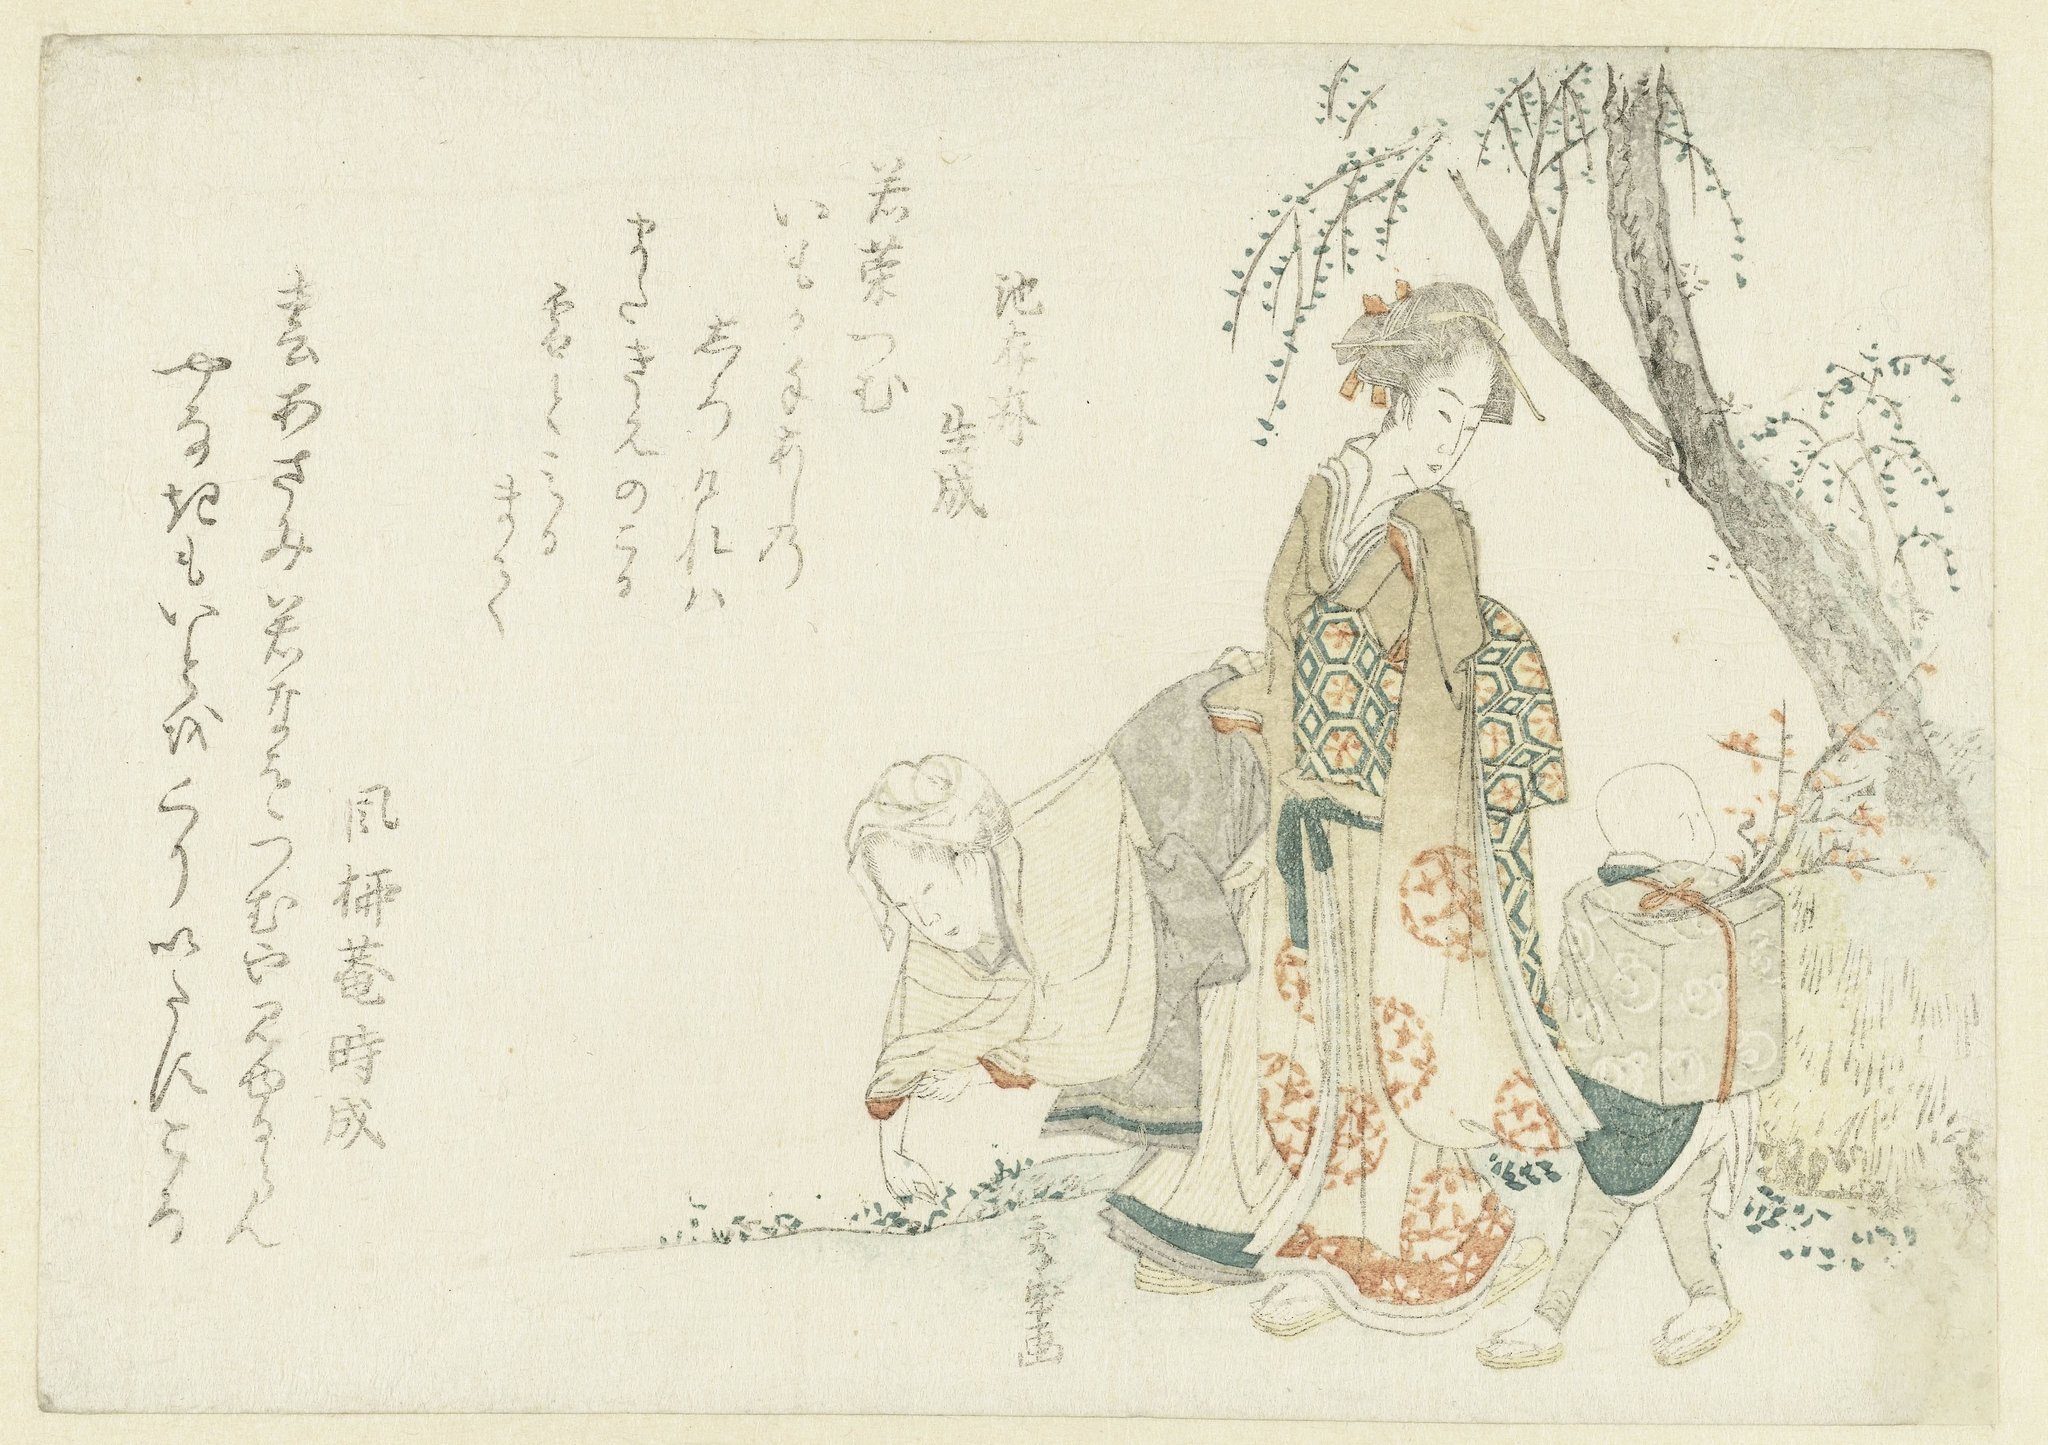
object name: print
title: Gathering the Seven Herbs of Spring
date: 1800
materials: paper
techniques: blind stamped, woodcut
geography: japan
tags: trees, boy (child between toddler and youth), gathering herbs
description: Een surimono is een luxe uitgevoerde prent waarop beeld met één of meerdere gedichten gecombineerd is. Bij het drukken van een surimono werd vaak gebruik gemaakt van dikker papier, blinddruk en metaal pigmenten, zoals koper- en zilverpoeder. De prenten werden vaak in opdracht van dichters gemaakt en als exclusief geschenk aan vrienden en relaties gegeven.